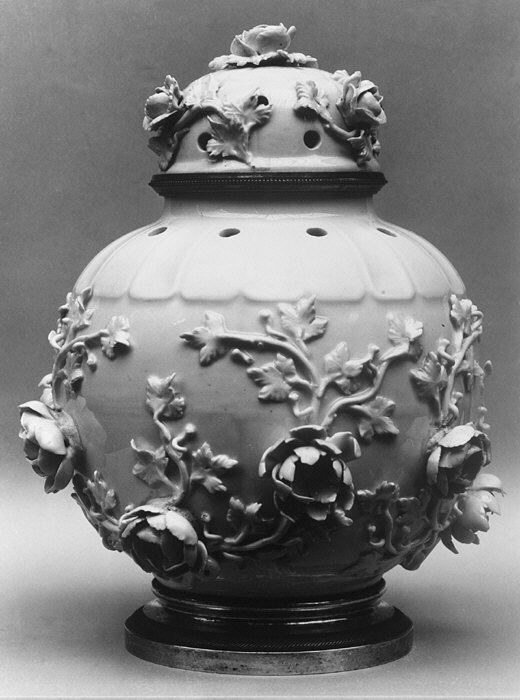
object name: potpourri jar with cover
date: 1801-1900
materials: hard paste porcelain, silver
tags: flowers